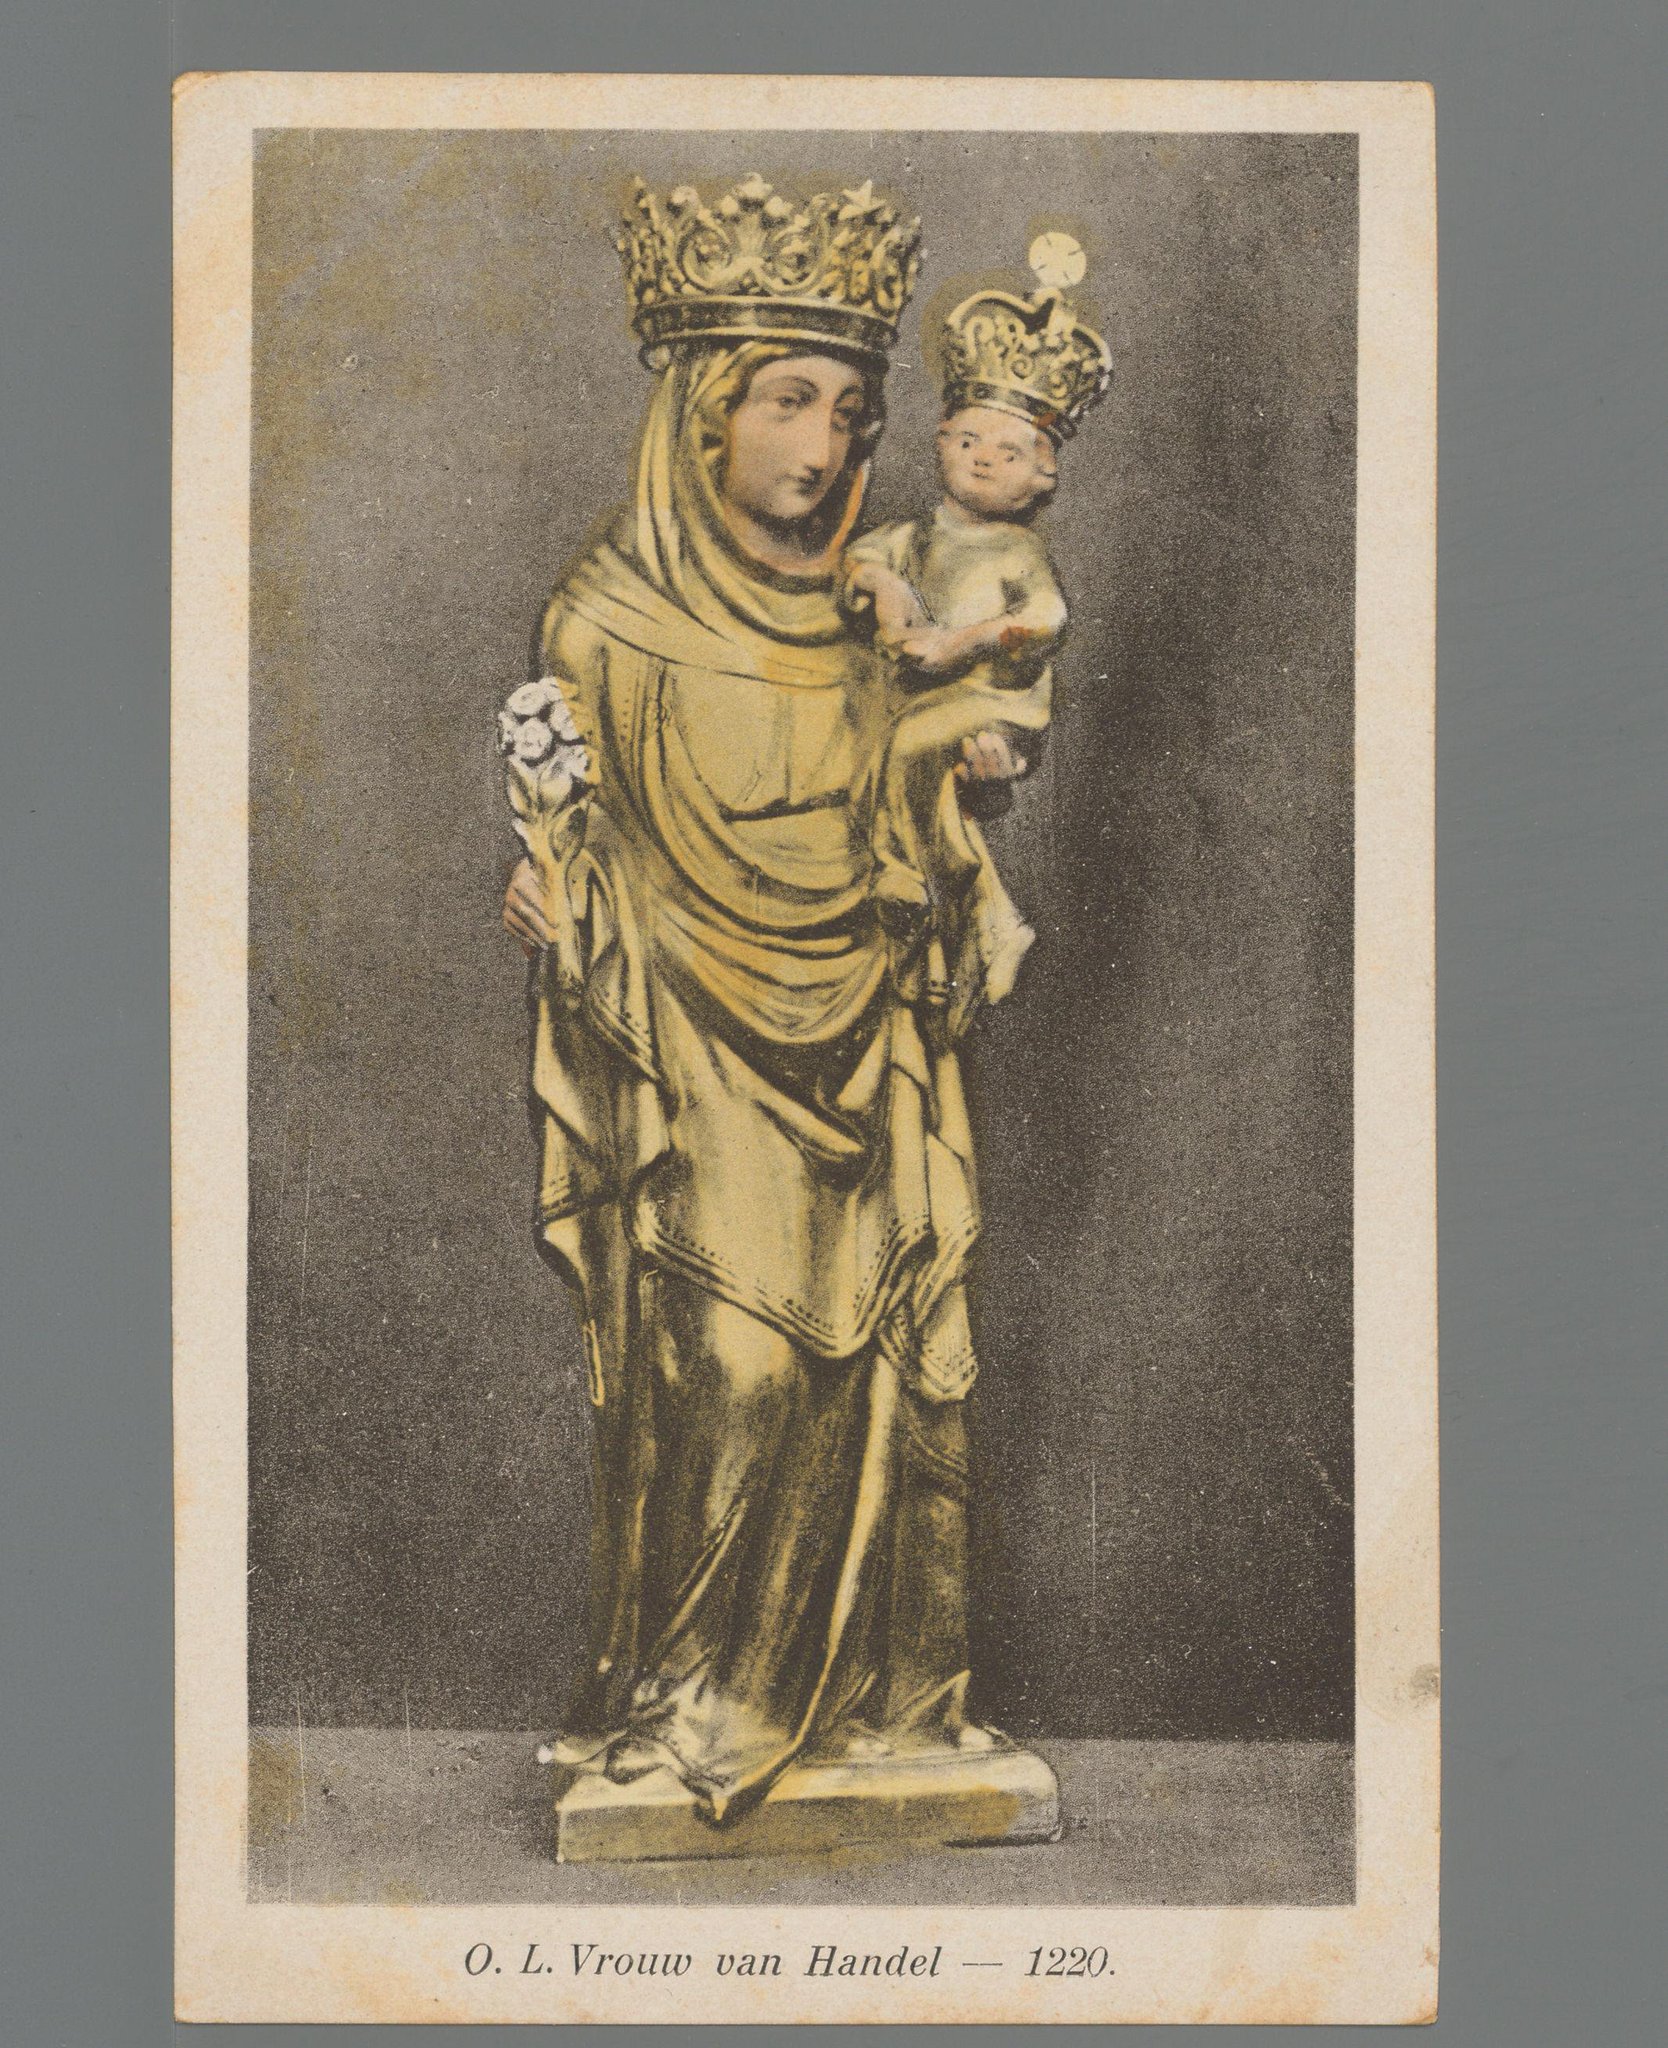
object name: photomechanical print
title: O.L. Vrouw van Handel - 1220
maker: Anonymous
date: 1913-1950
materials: cardboard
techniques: photograph, lithograph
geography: helmond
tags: monument, statue